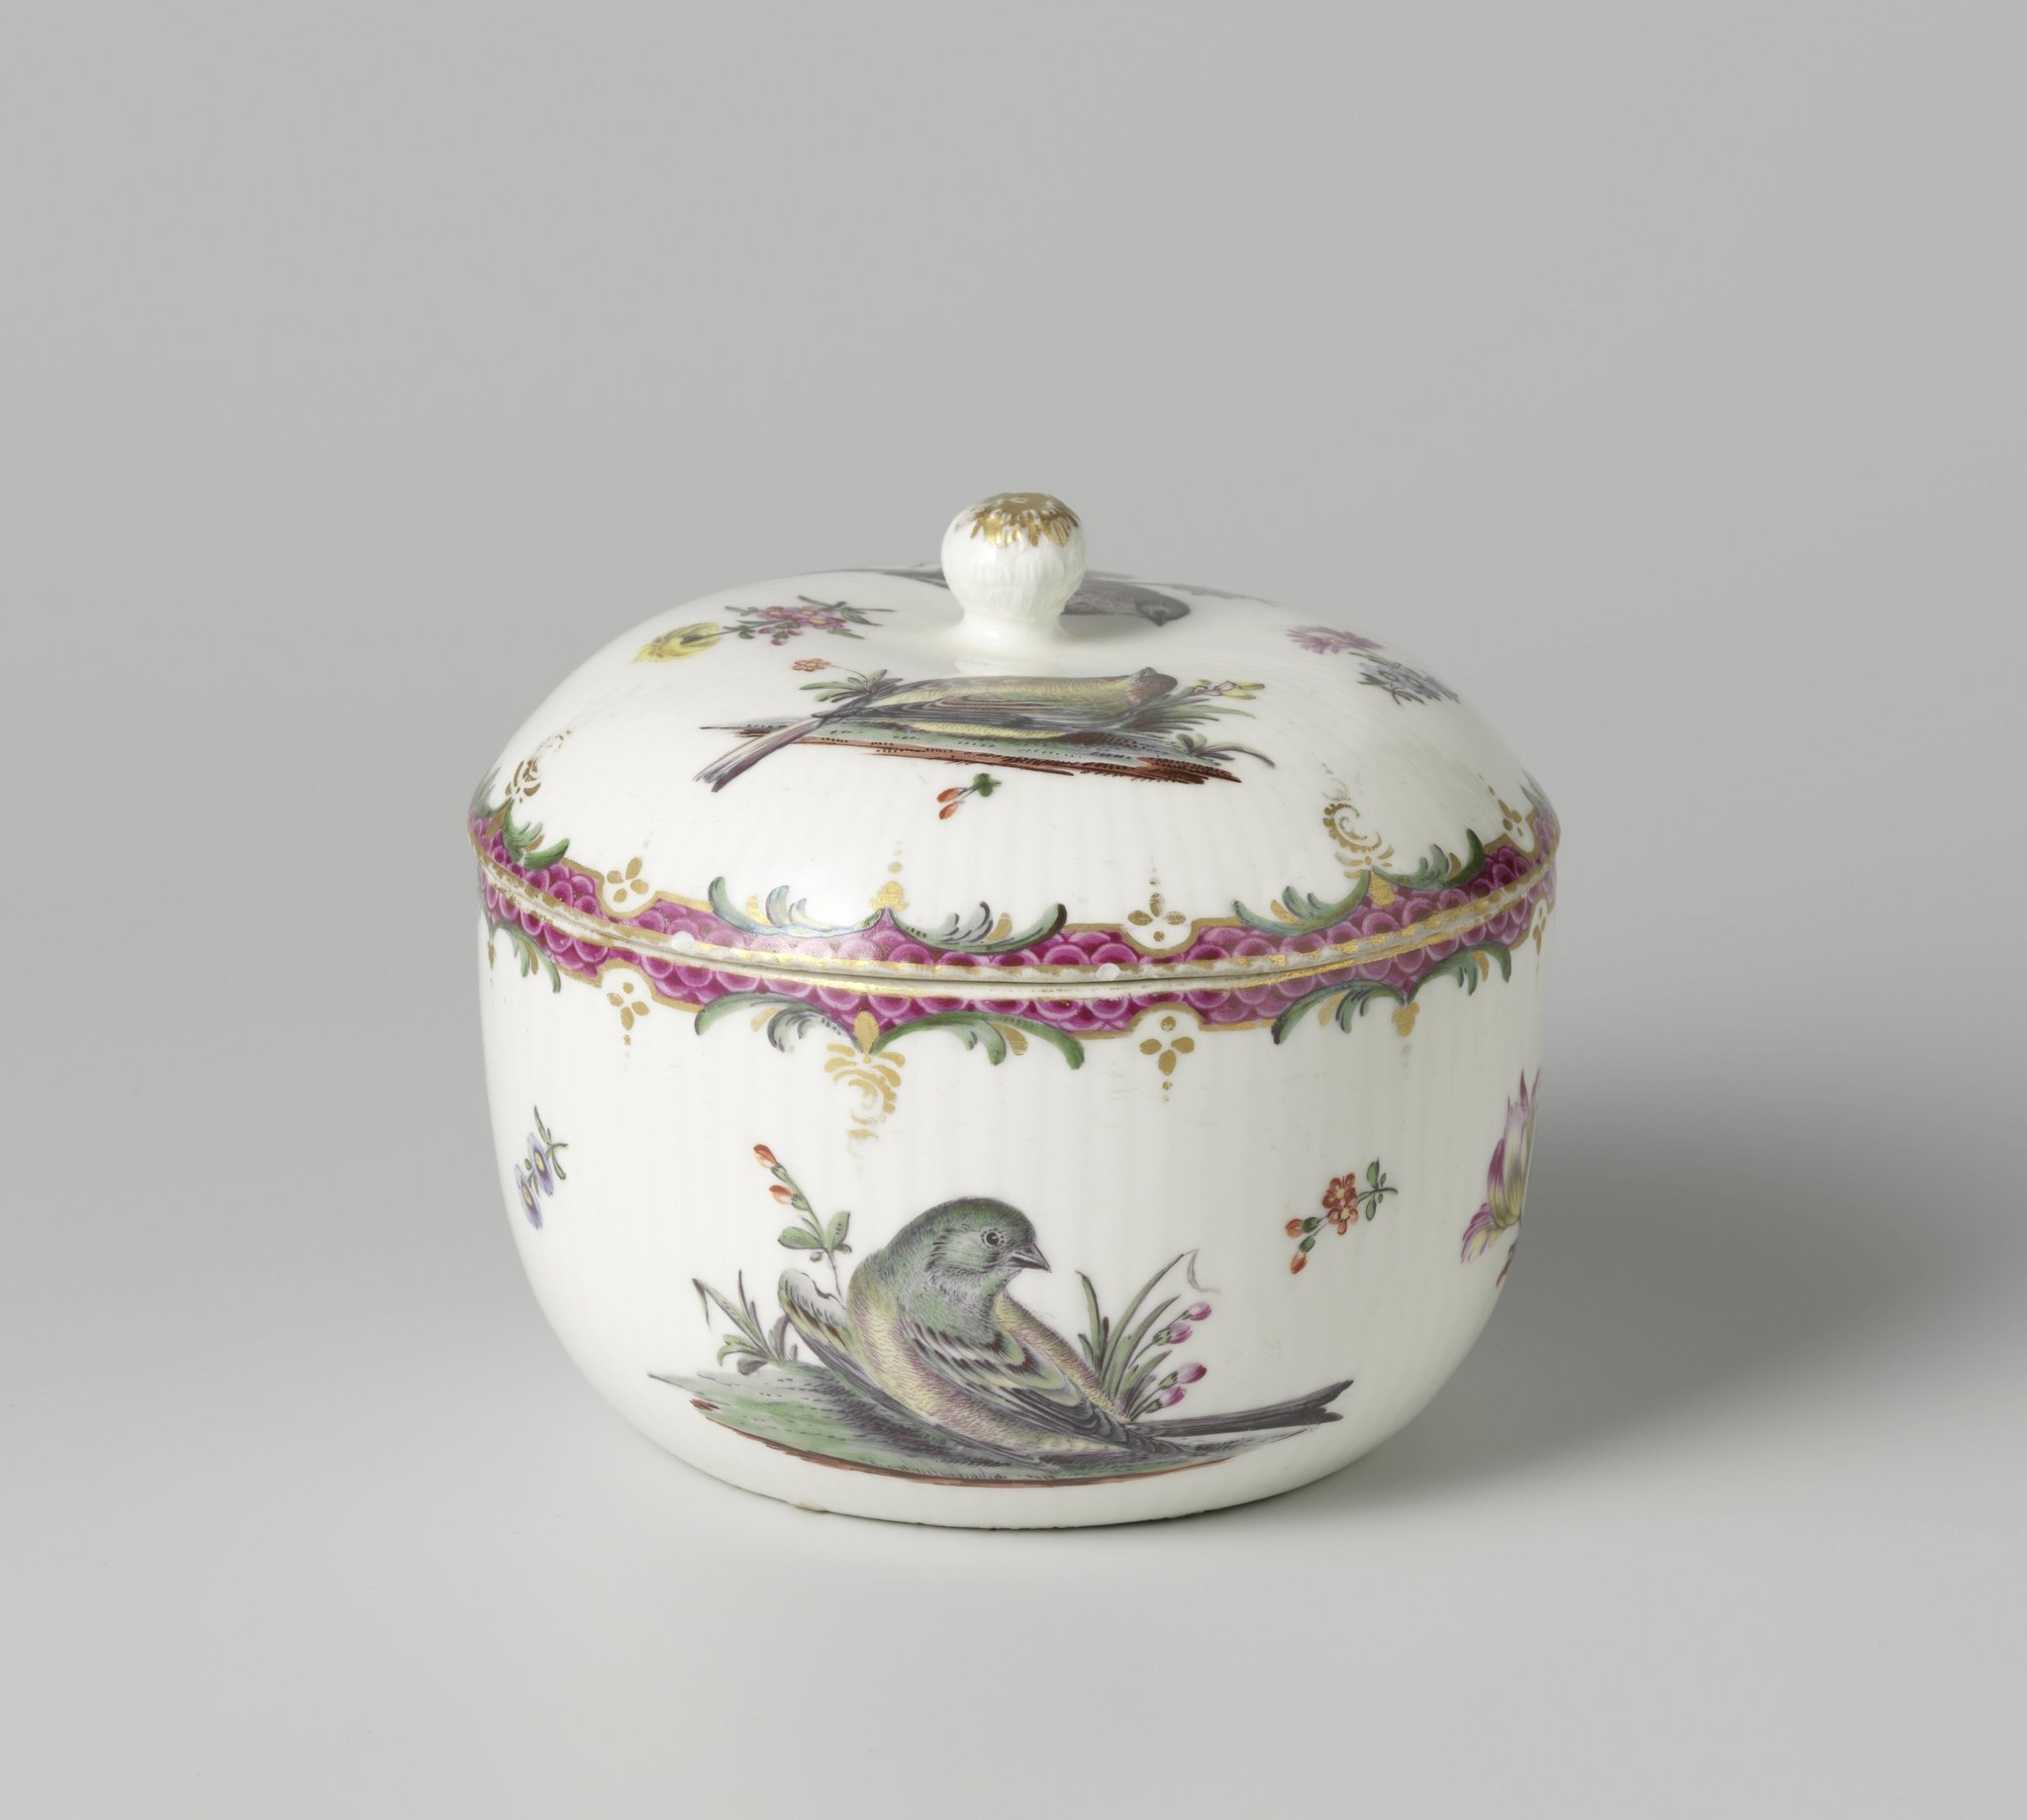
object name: covered bowl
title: Covered bowl with a putto in a medallion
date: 1765-1775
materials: glaze, gold, paint, porcelain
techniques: firing, forming, gilding, turning, vitrification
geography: furstenberg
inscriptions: mark: ‘F/ ZO[20?]/ Nor. A’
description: Bowl and cover. Porcelain. Fürstenberg, c. 1765 - 1775. Given by Jonkheer J.E. van Heemskerck van Beest, 1877.